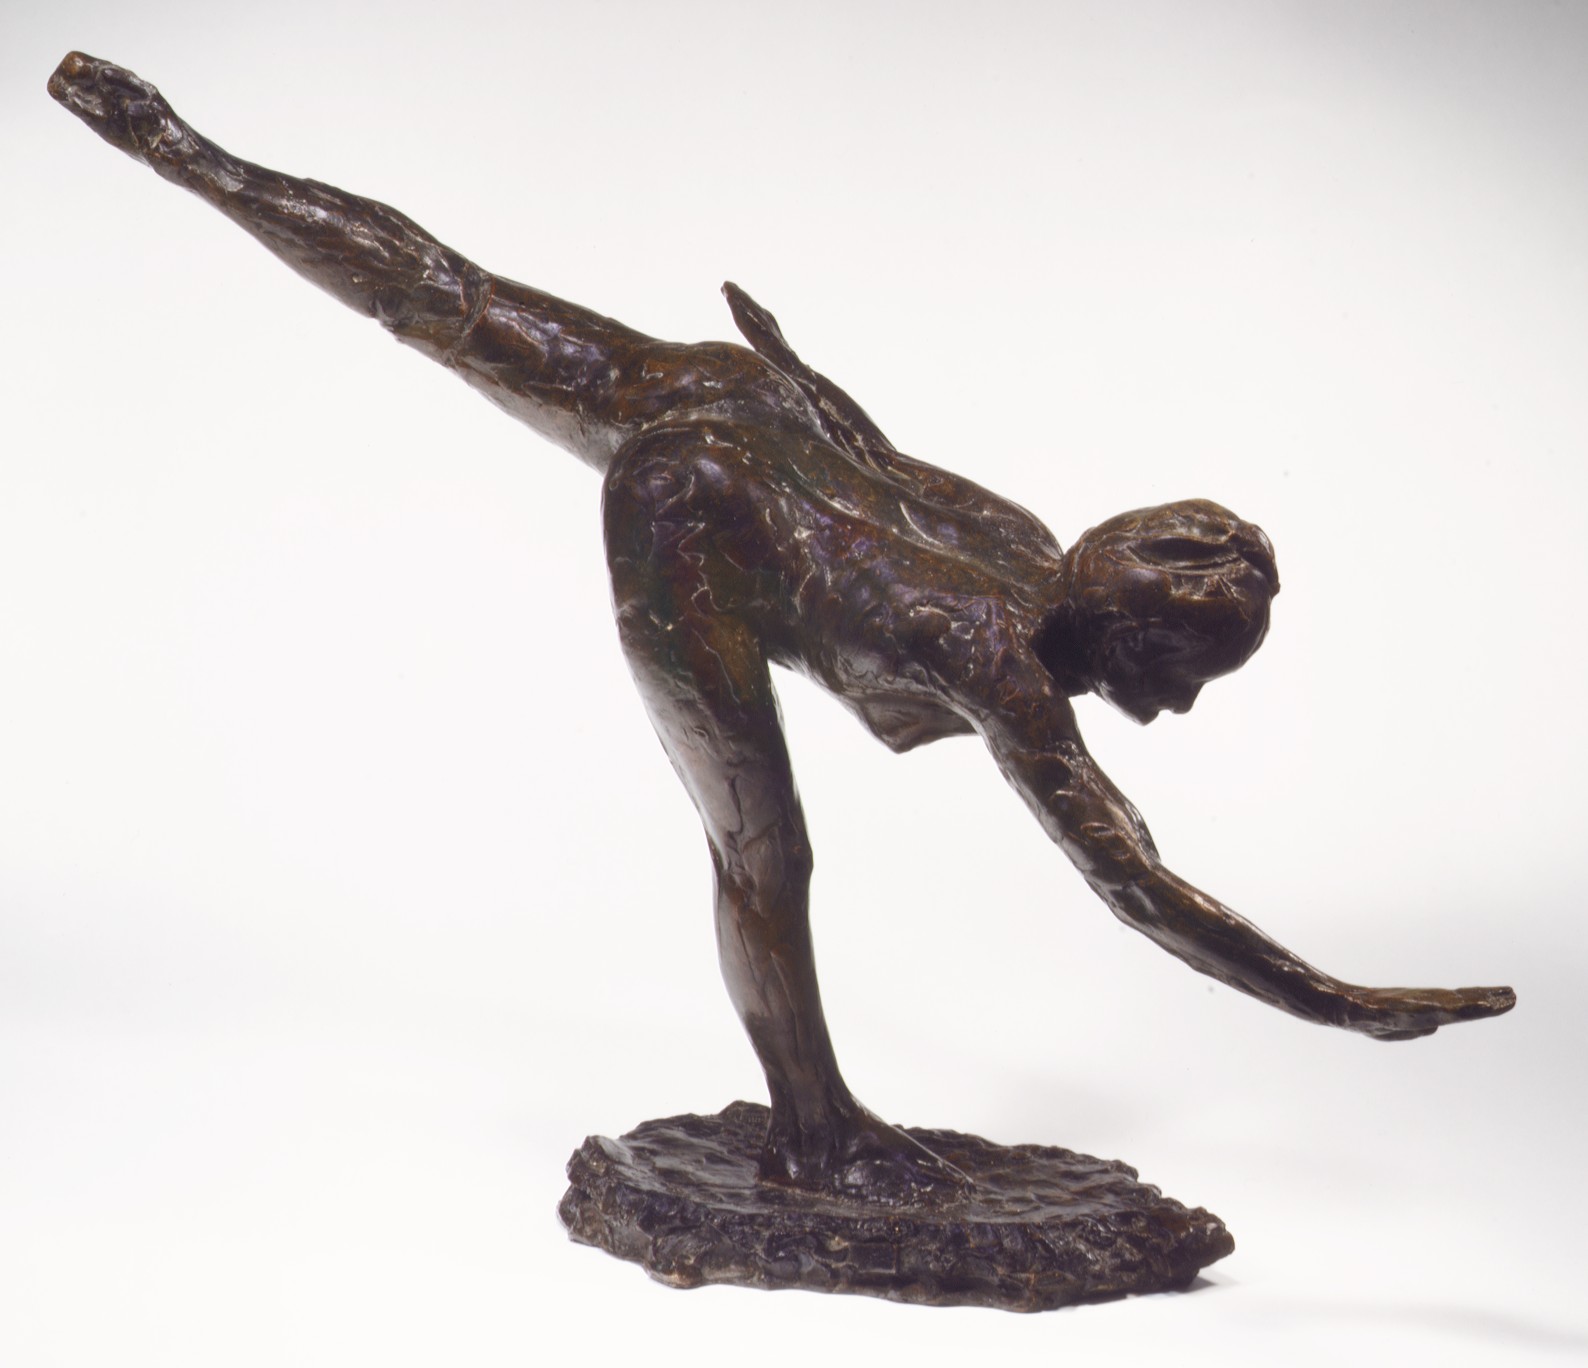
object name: statuette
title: First Arabesque Penché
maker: edgar degas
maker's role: artist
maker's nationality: french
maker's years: 1834-1917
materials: bronze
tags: female nudes,dancing,ballet